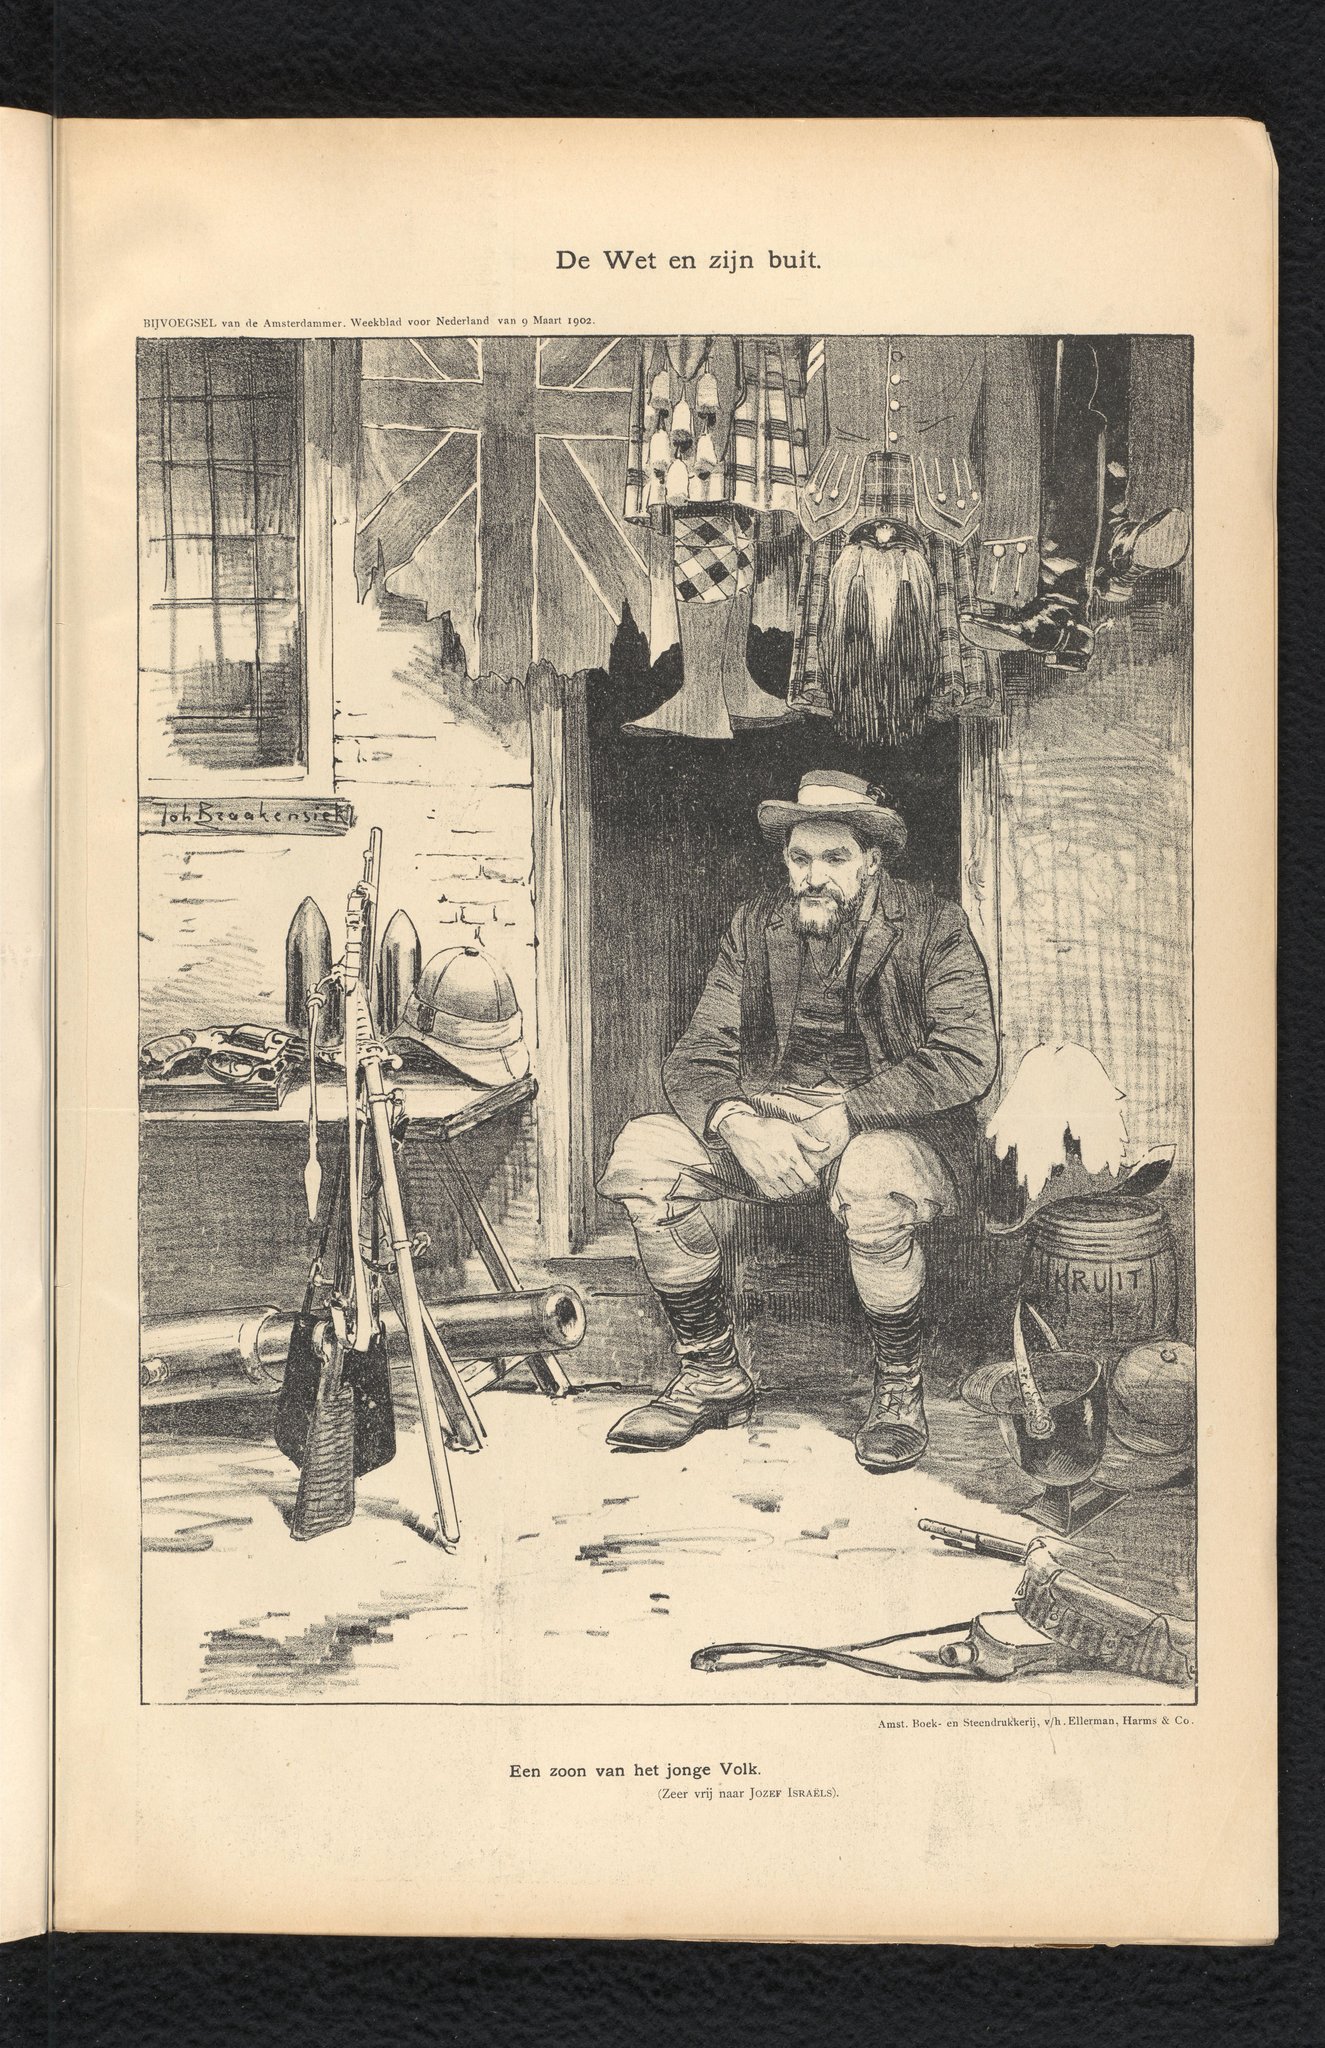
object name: cartoon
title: De Wet en zijn buit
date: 1902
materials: paper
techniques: lithograph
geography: amsterdam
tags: politician, firearms, political caricatures and satires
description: Boerengeneraal Christiaan de Wet zittend tussen buitgemaakte Engelse wapens, uniformen en vlaggen.